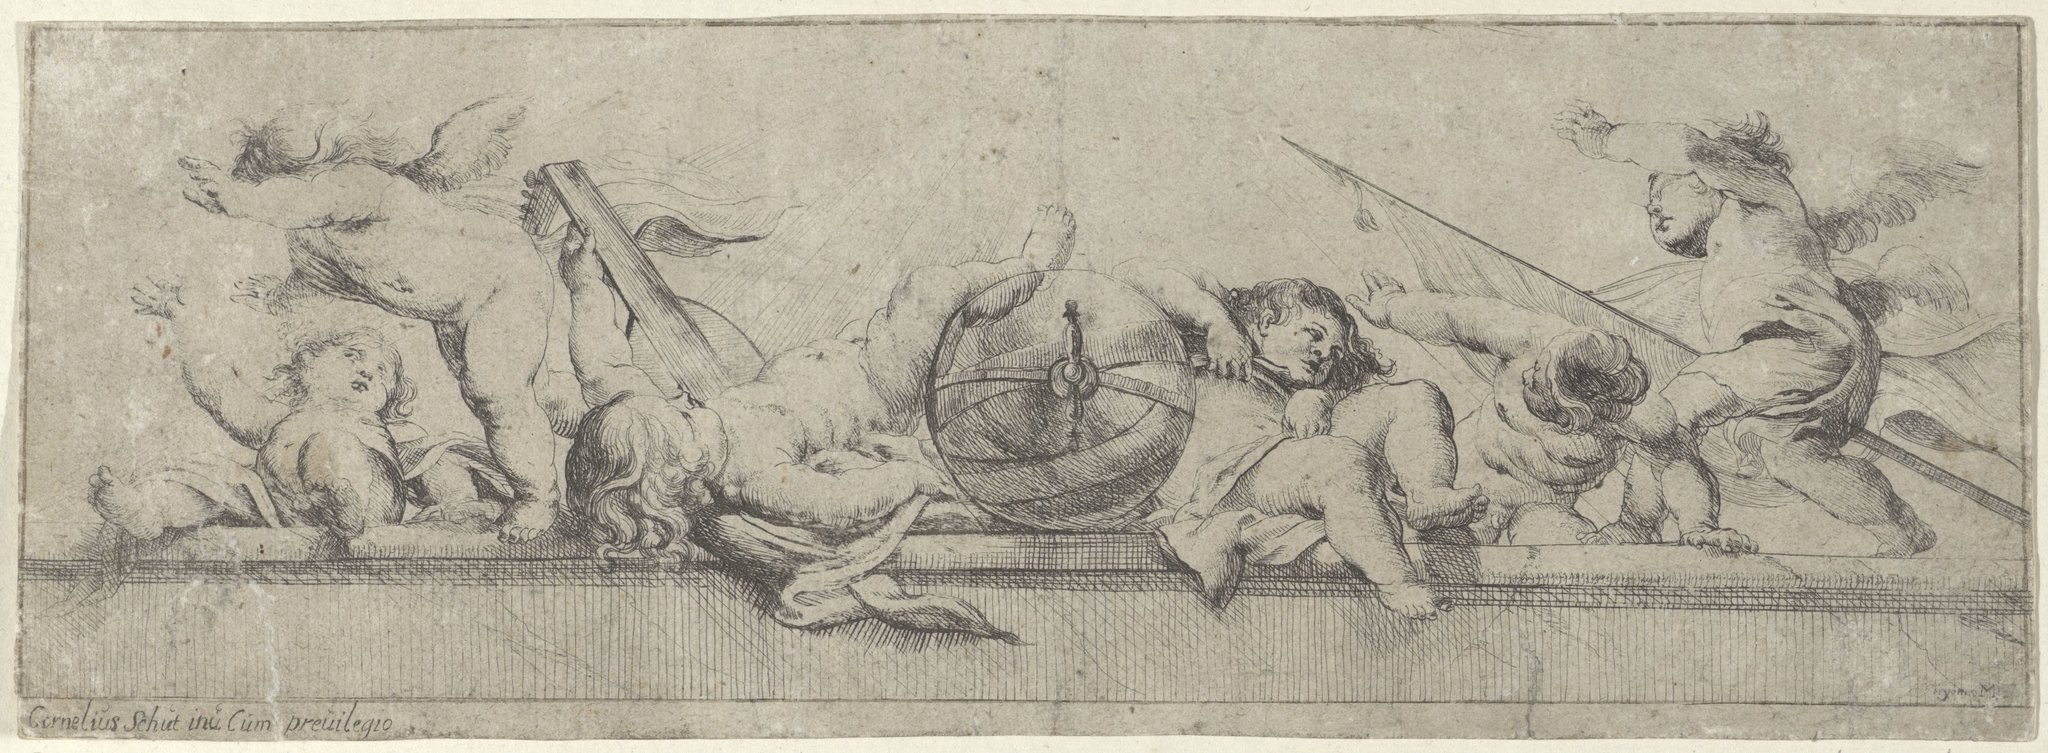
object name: print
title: Fries met zes putti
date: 1618-1655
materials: paper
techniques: engraving, etching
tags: flags (~ signalling), lute, and special forms of lute, e.g.: theorbo, globe, cupids: 'amores', 'amoretti', 'putti'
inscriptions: collector's mark: Lugt 2228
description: Fries met zes putti rondom een globe. Een van de putti's draagt een vlag, een andere houdt een luit vast.